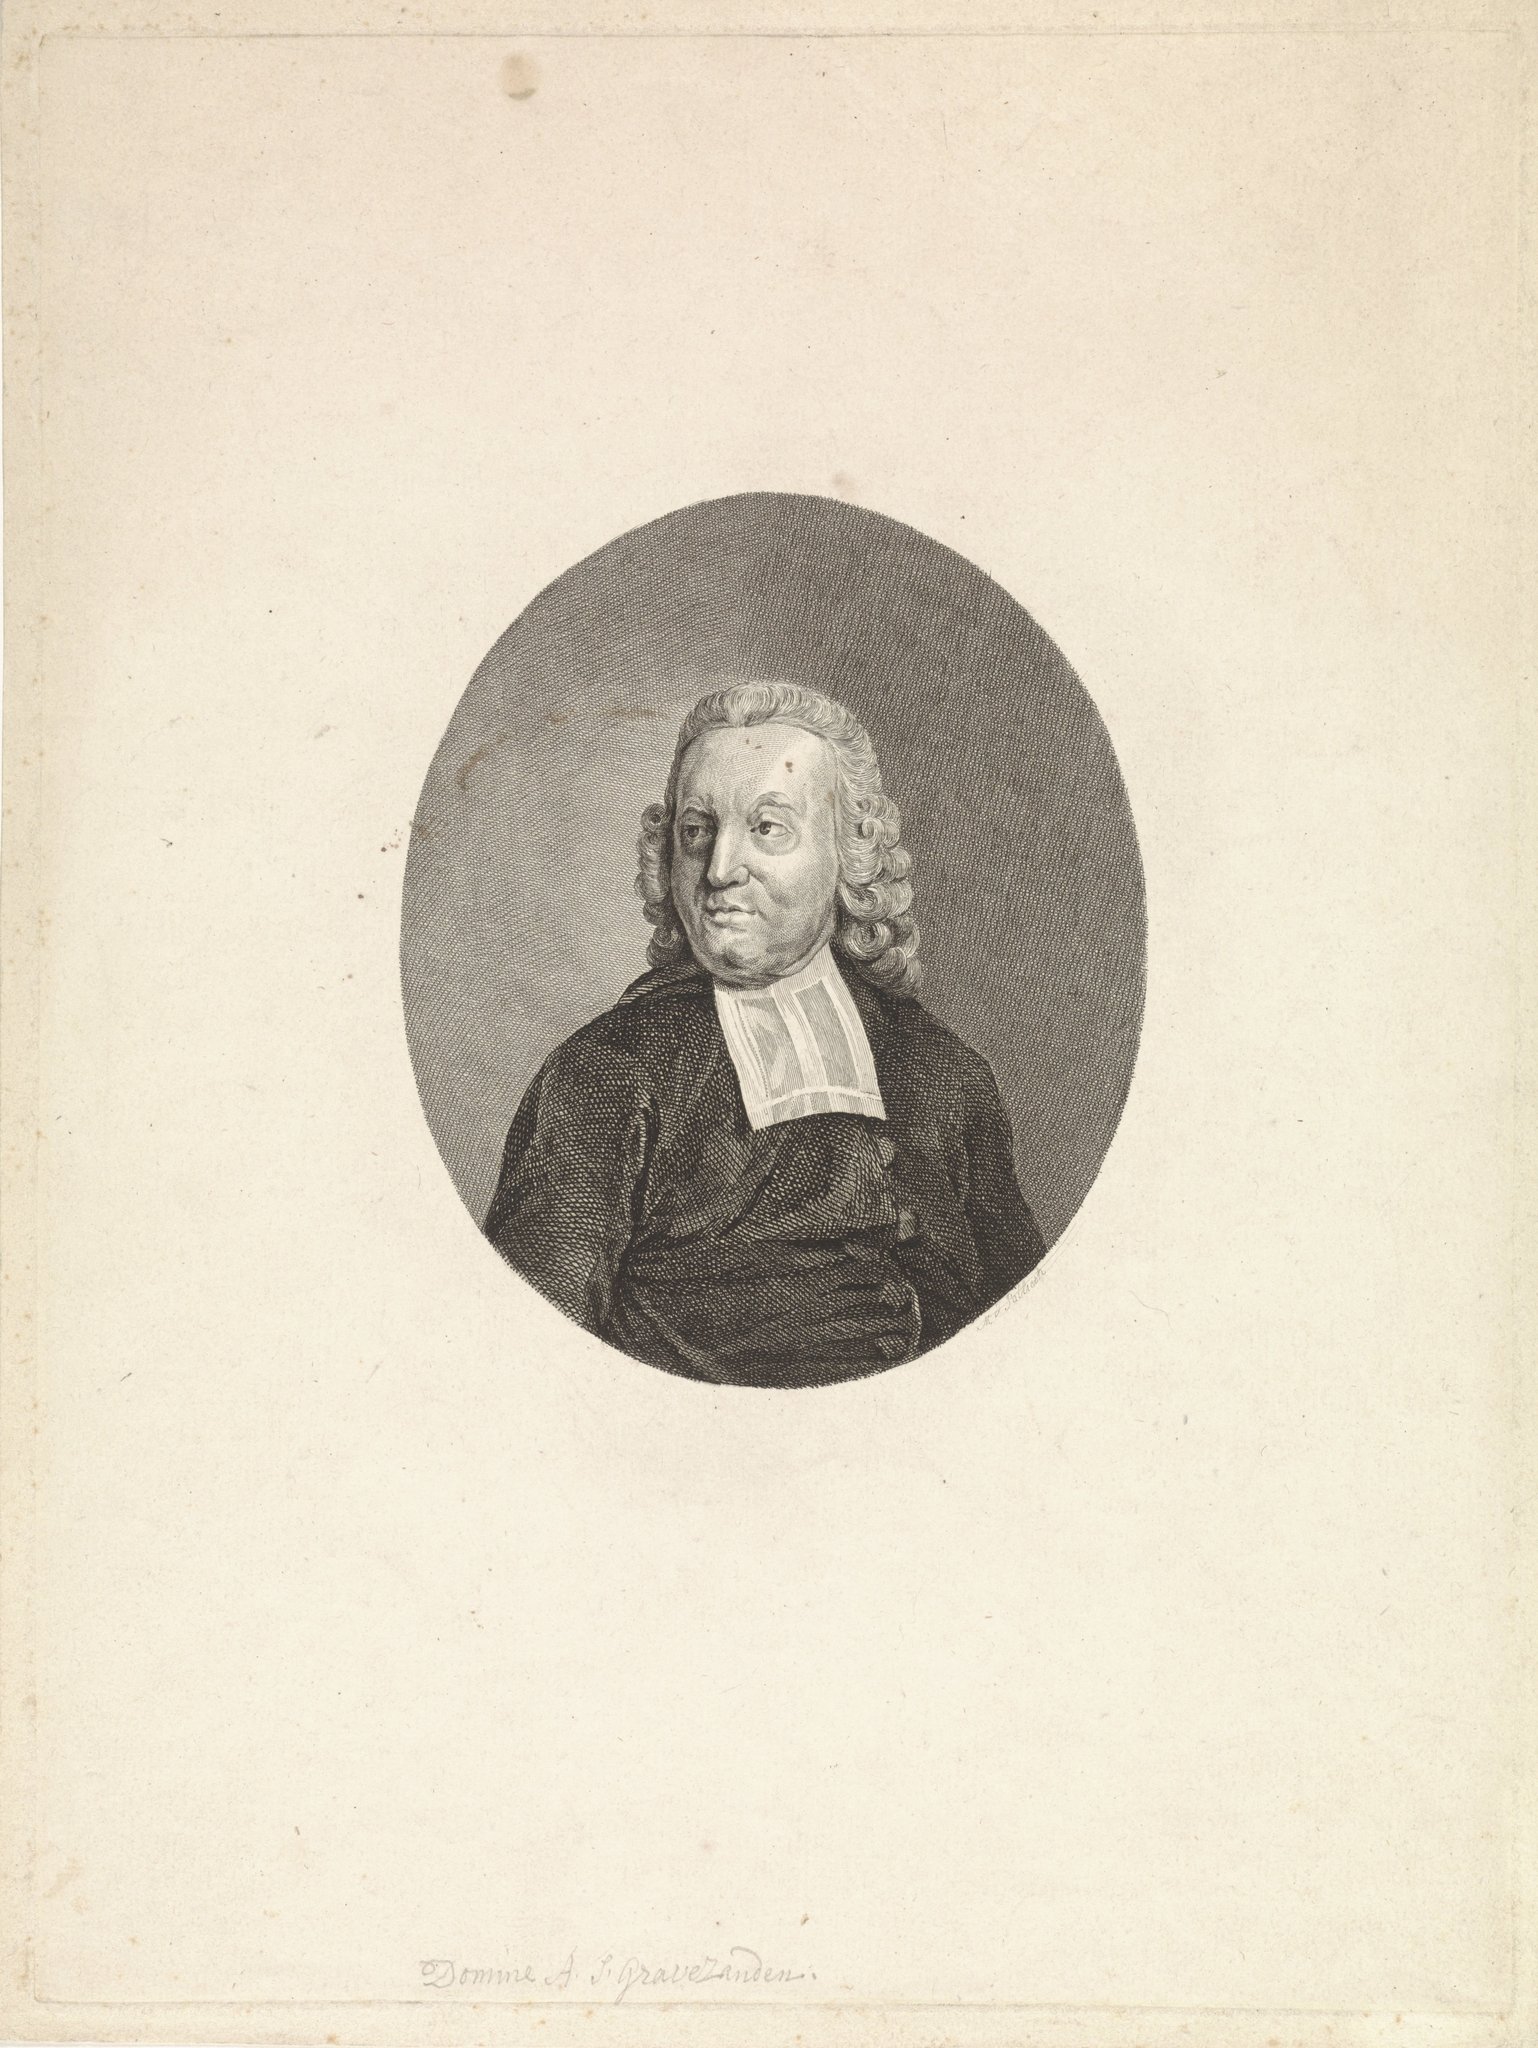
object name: print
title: Portret van de Zeeuwse predikant Adriaan 's Gravezande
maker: mathias de sallieth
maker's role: print maker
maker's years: 1749-1791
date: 1771-1791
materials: paper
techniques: etching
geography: rotterdam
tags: predikant, adriaan 's- gravezande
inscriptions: collector's mark: Lugt 2228